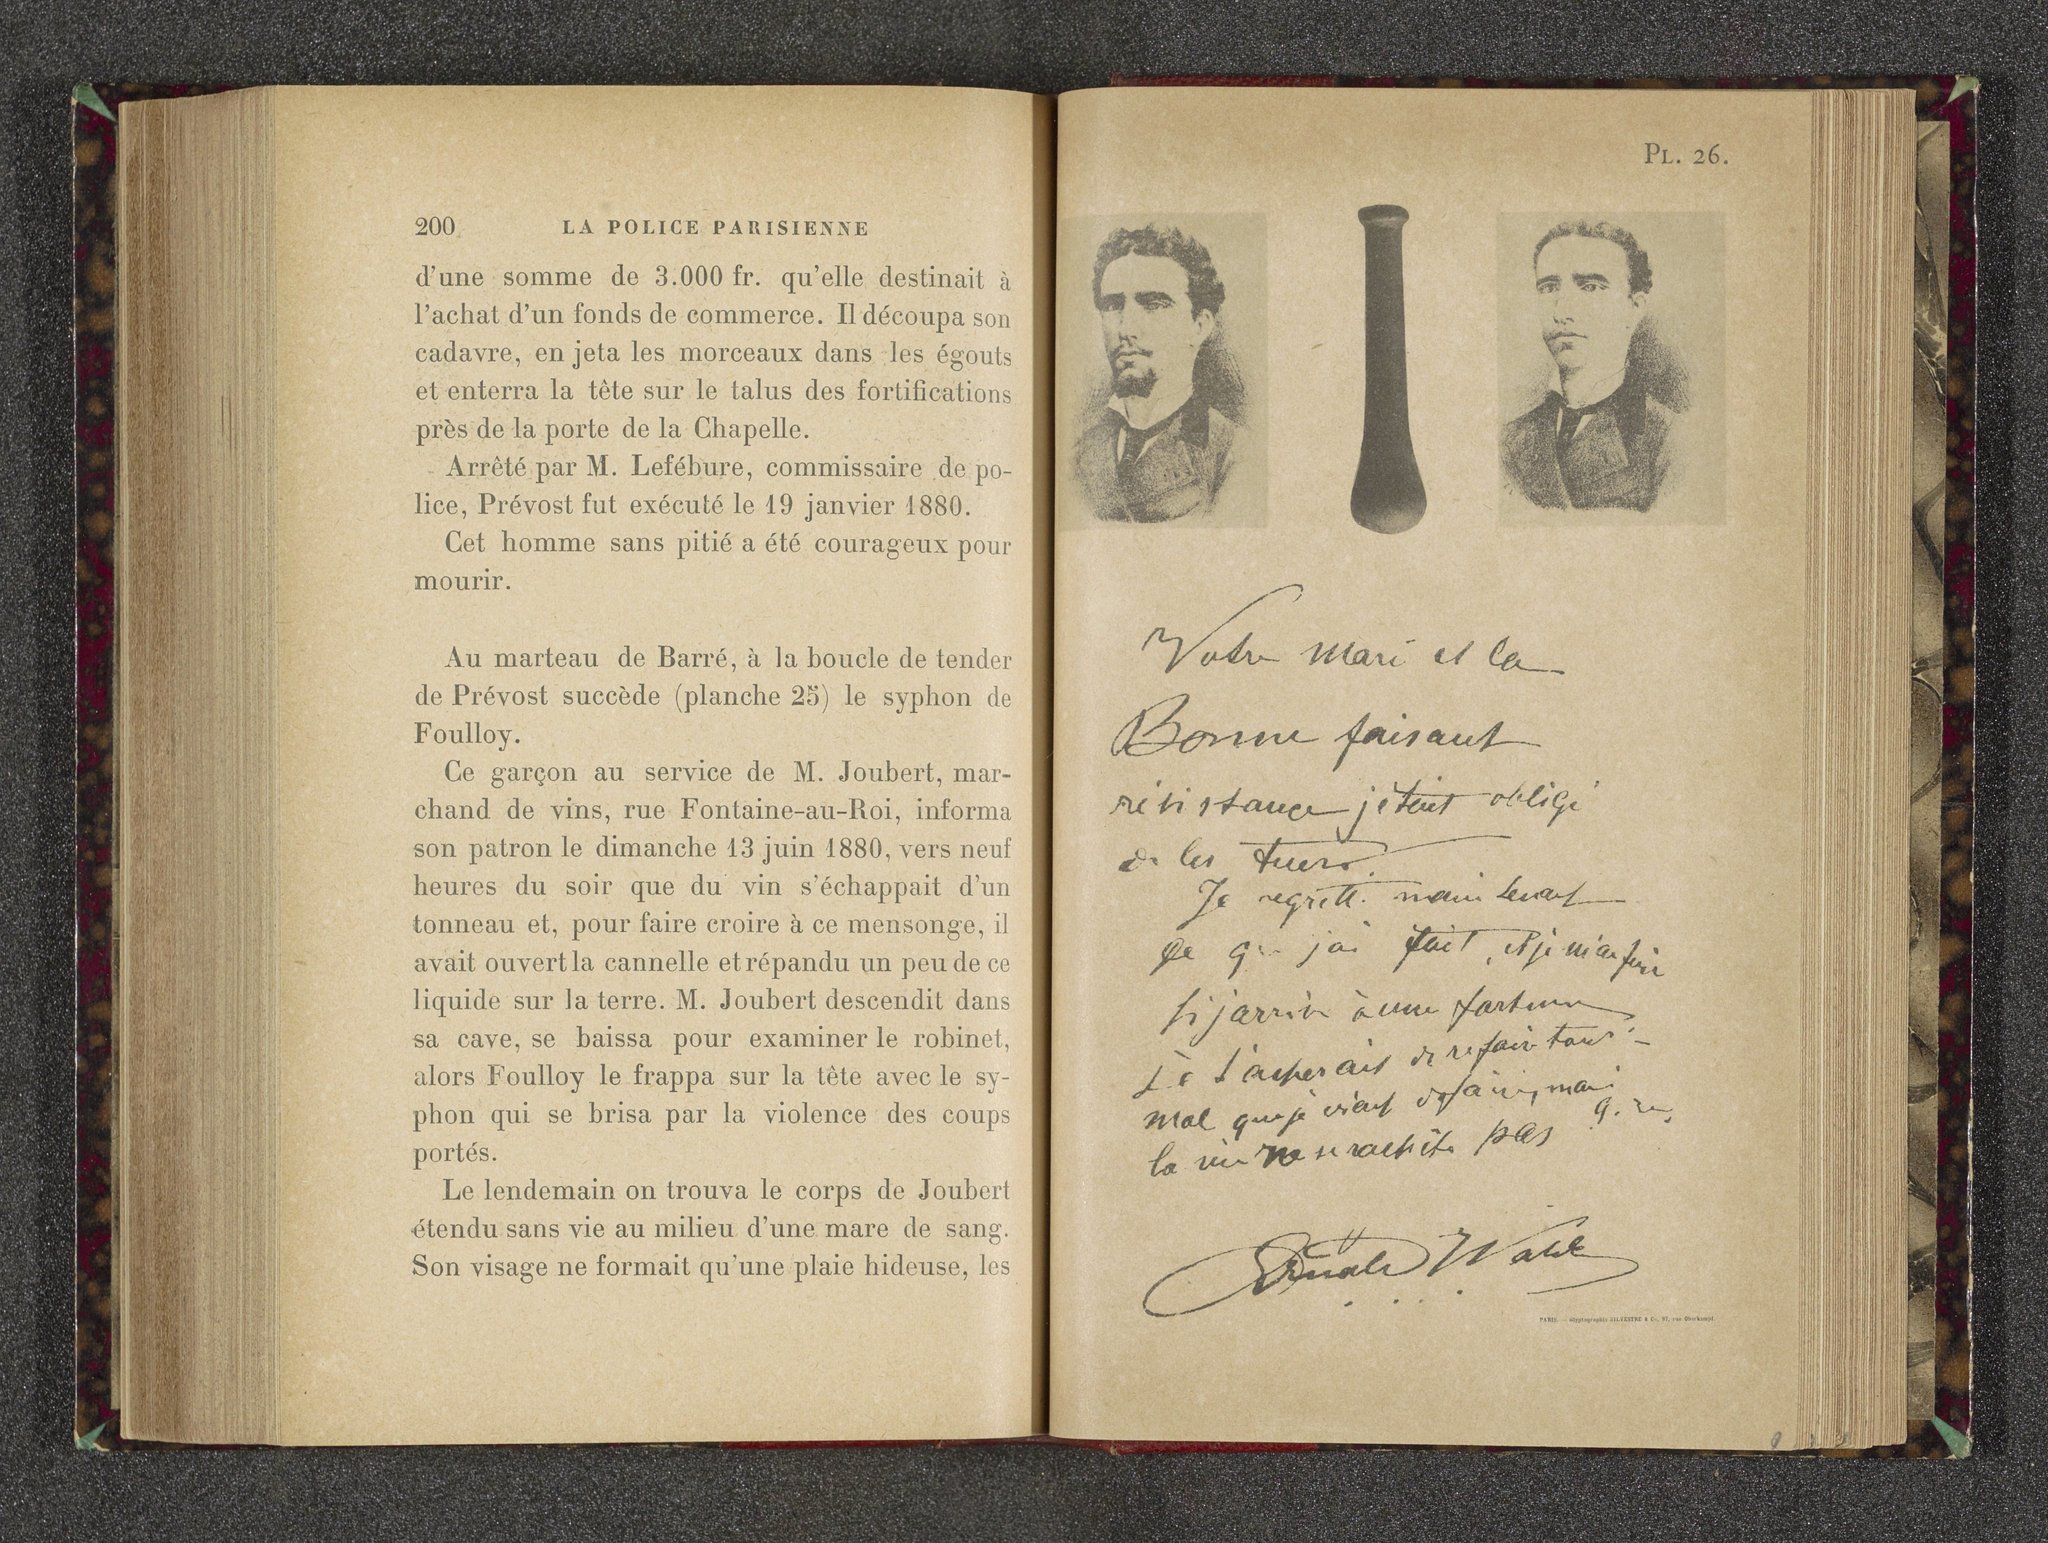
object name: page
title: Twee compositietekeningen van een moordenaar, een stamper en een brief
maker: Anonymous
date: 1880-1890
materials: paper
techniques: photograph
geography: france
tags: murder, criminals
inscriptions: number: ‘Pl. 26.’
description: De stamper is gebruikt om een dubbele moord te plegen.